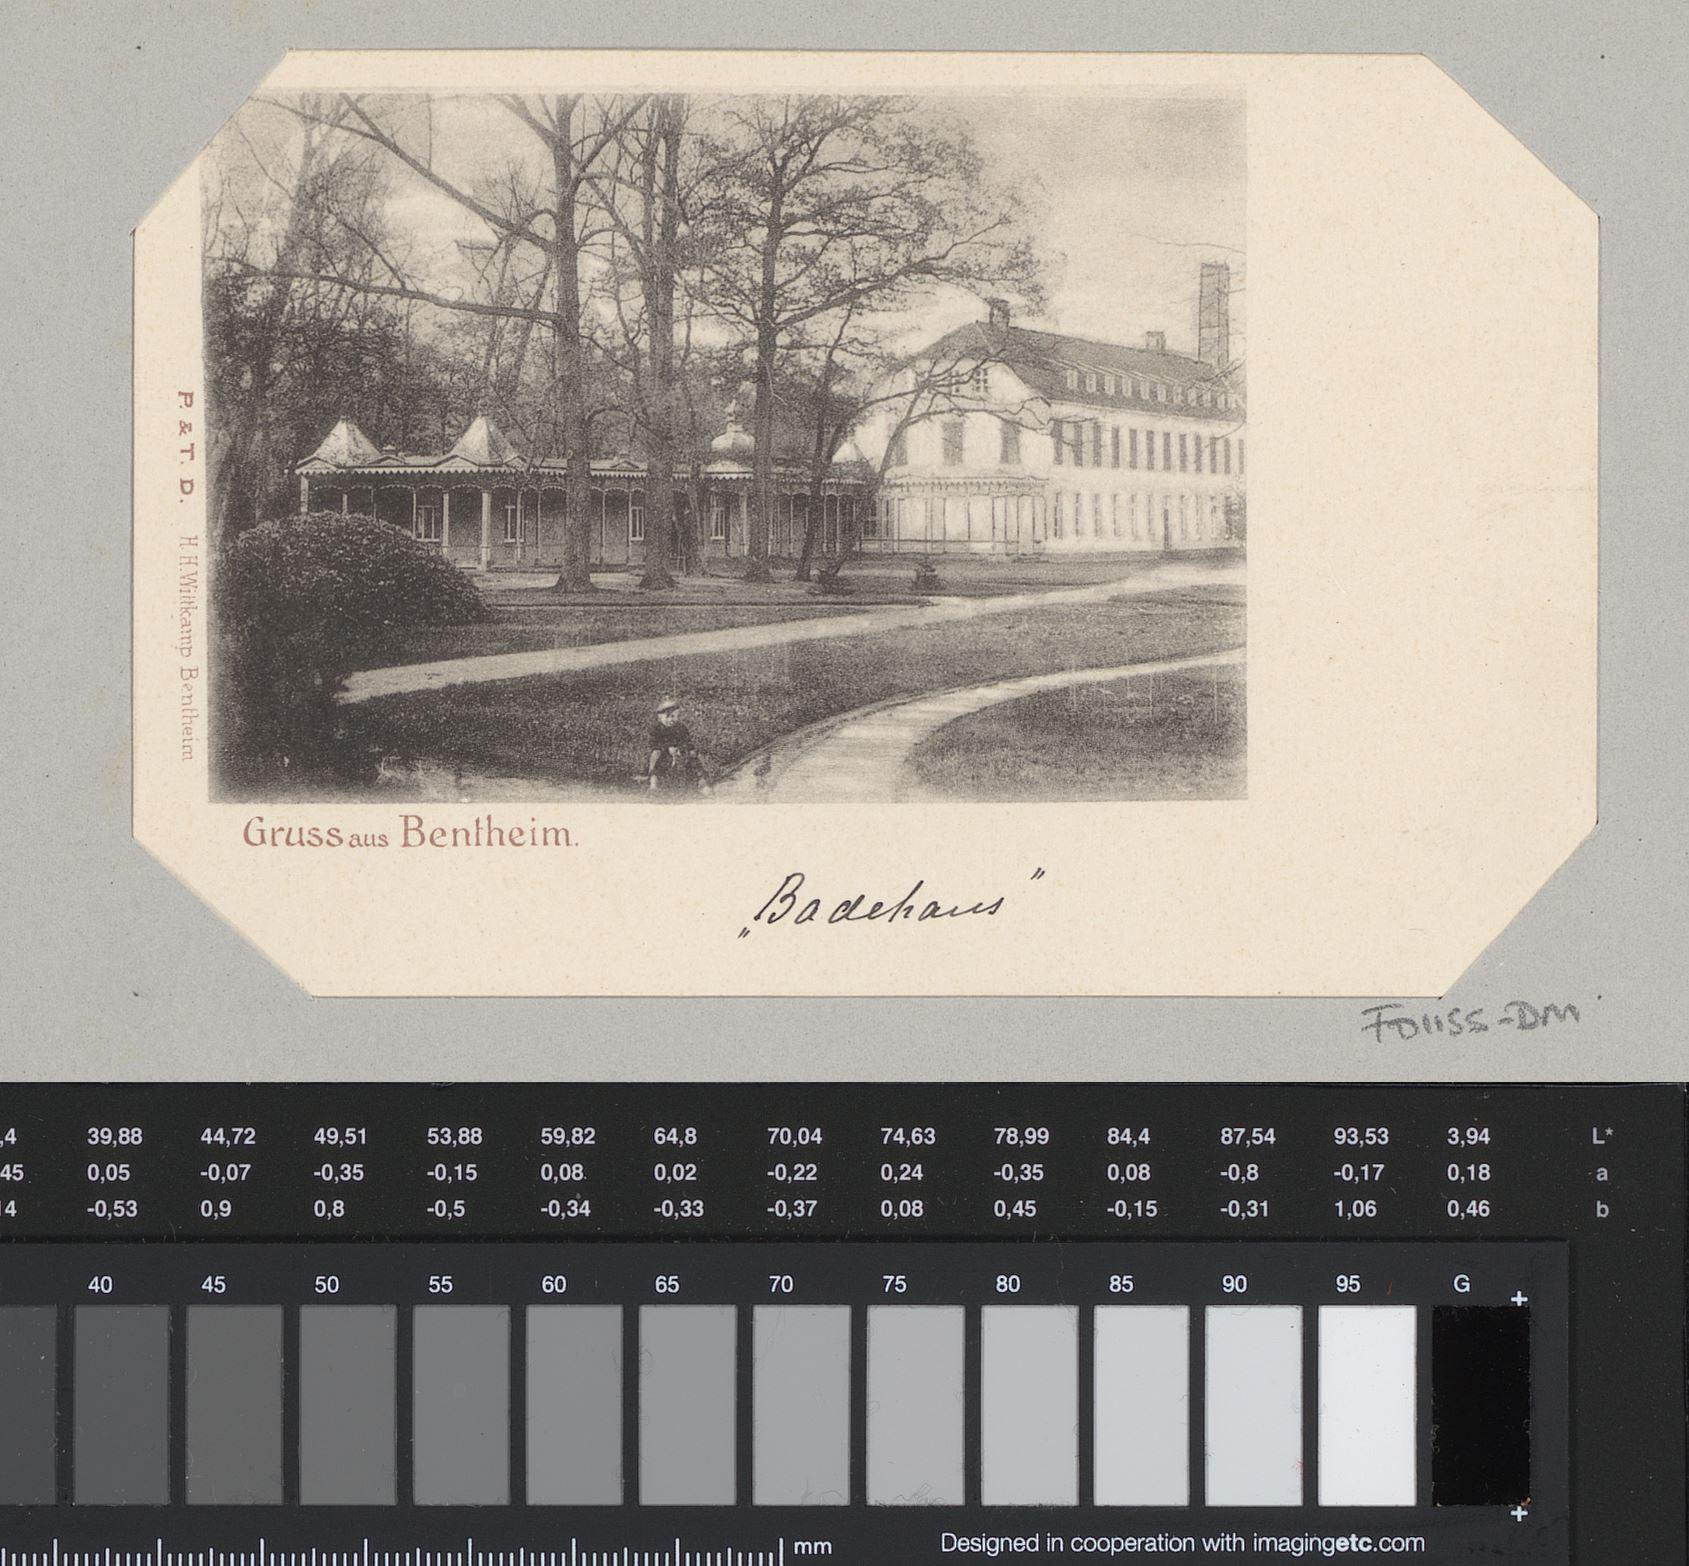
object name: album leaf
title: Gezicht op het badhuis te Bentheim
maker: heinrich h. wittkamp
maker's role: fotograaf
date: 1895-1903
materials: cardboard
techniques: photograph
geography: bentheim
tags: watering-place, spa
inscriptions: annotation: ‘Badehaus’, annotation: ‘Reis Bentheim van 12-21 juli 1903’, inscription: ‘P. & T.D. H.H. Wittkamp Bentheim/ Gruss aus Bentheim’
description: Deze prent maakt deel uit van een album.